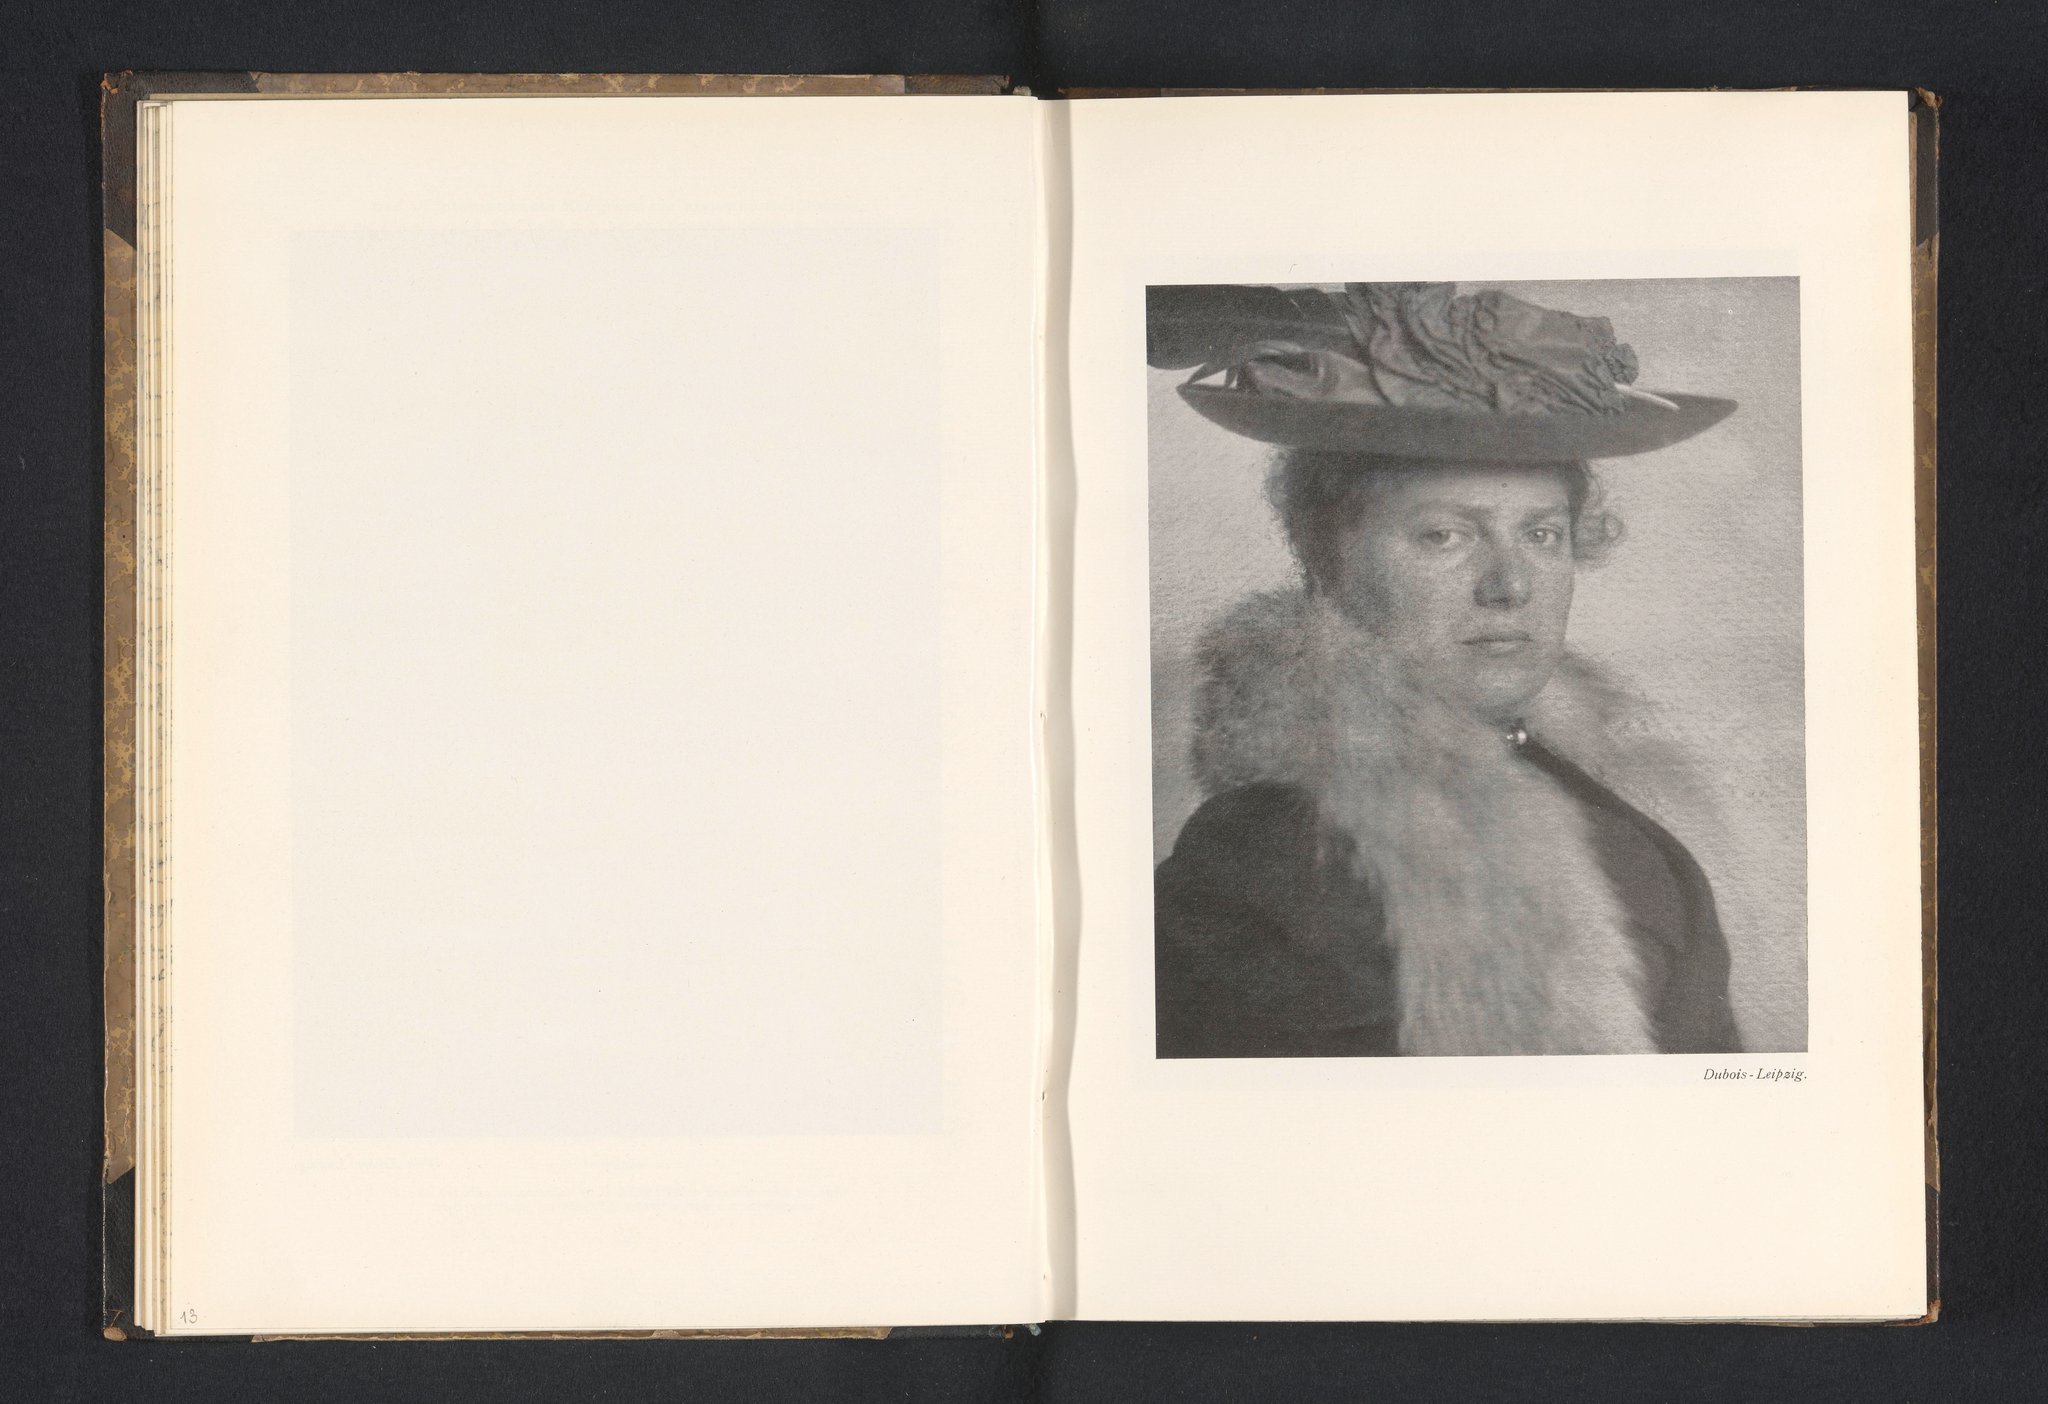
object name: page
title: Portret van een onbekende vrouw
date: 1898-1903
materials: paper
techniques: autotype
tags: historical persons not known by name - bb - woman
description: Prent op tweede ongenummerde pagina na pagina 28.